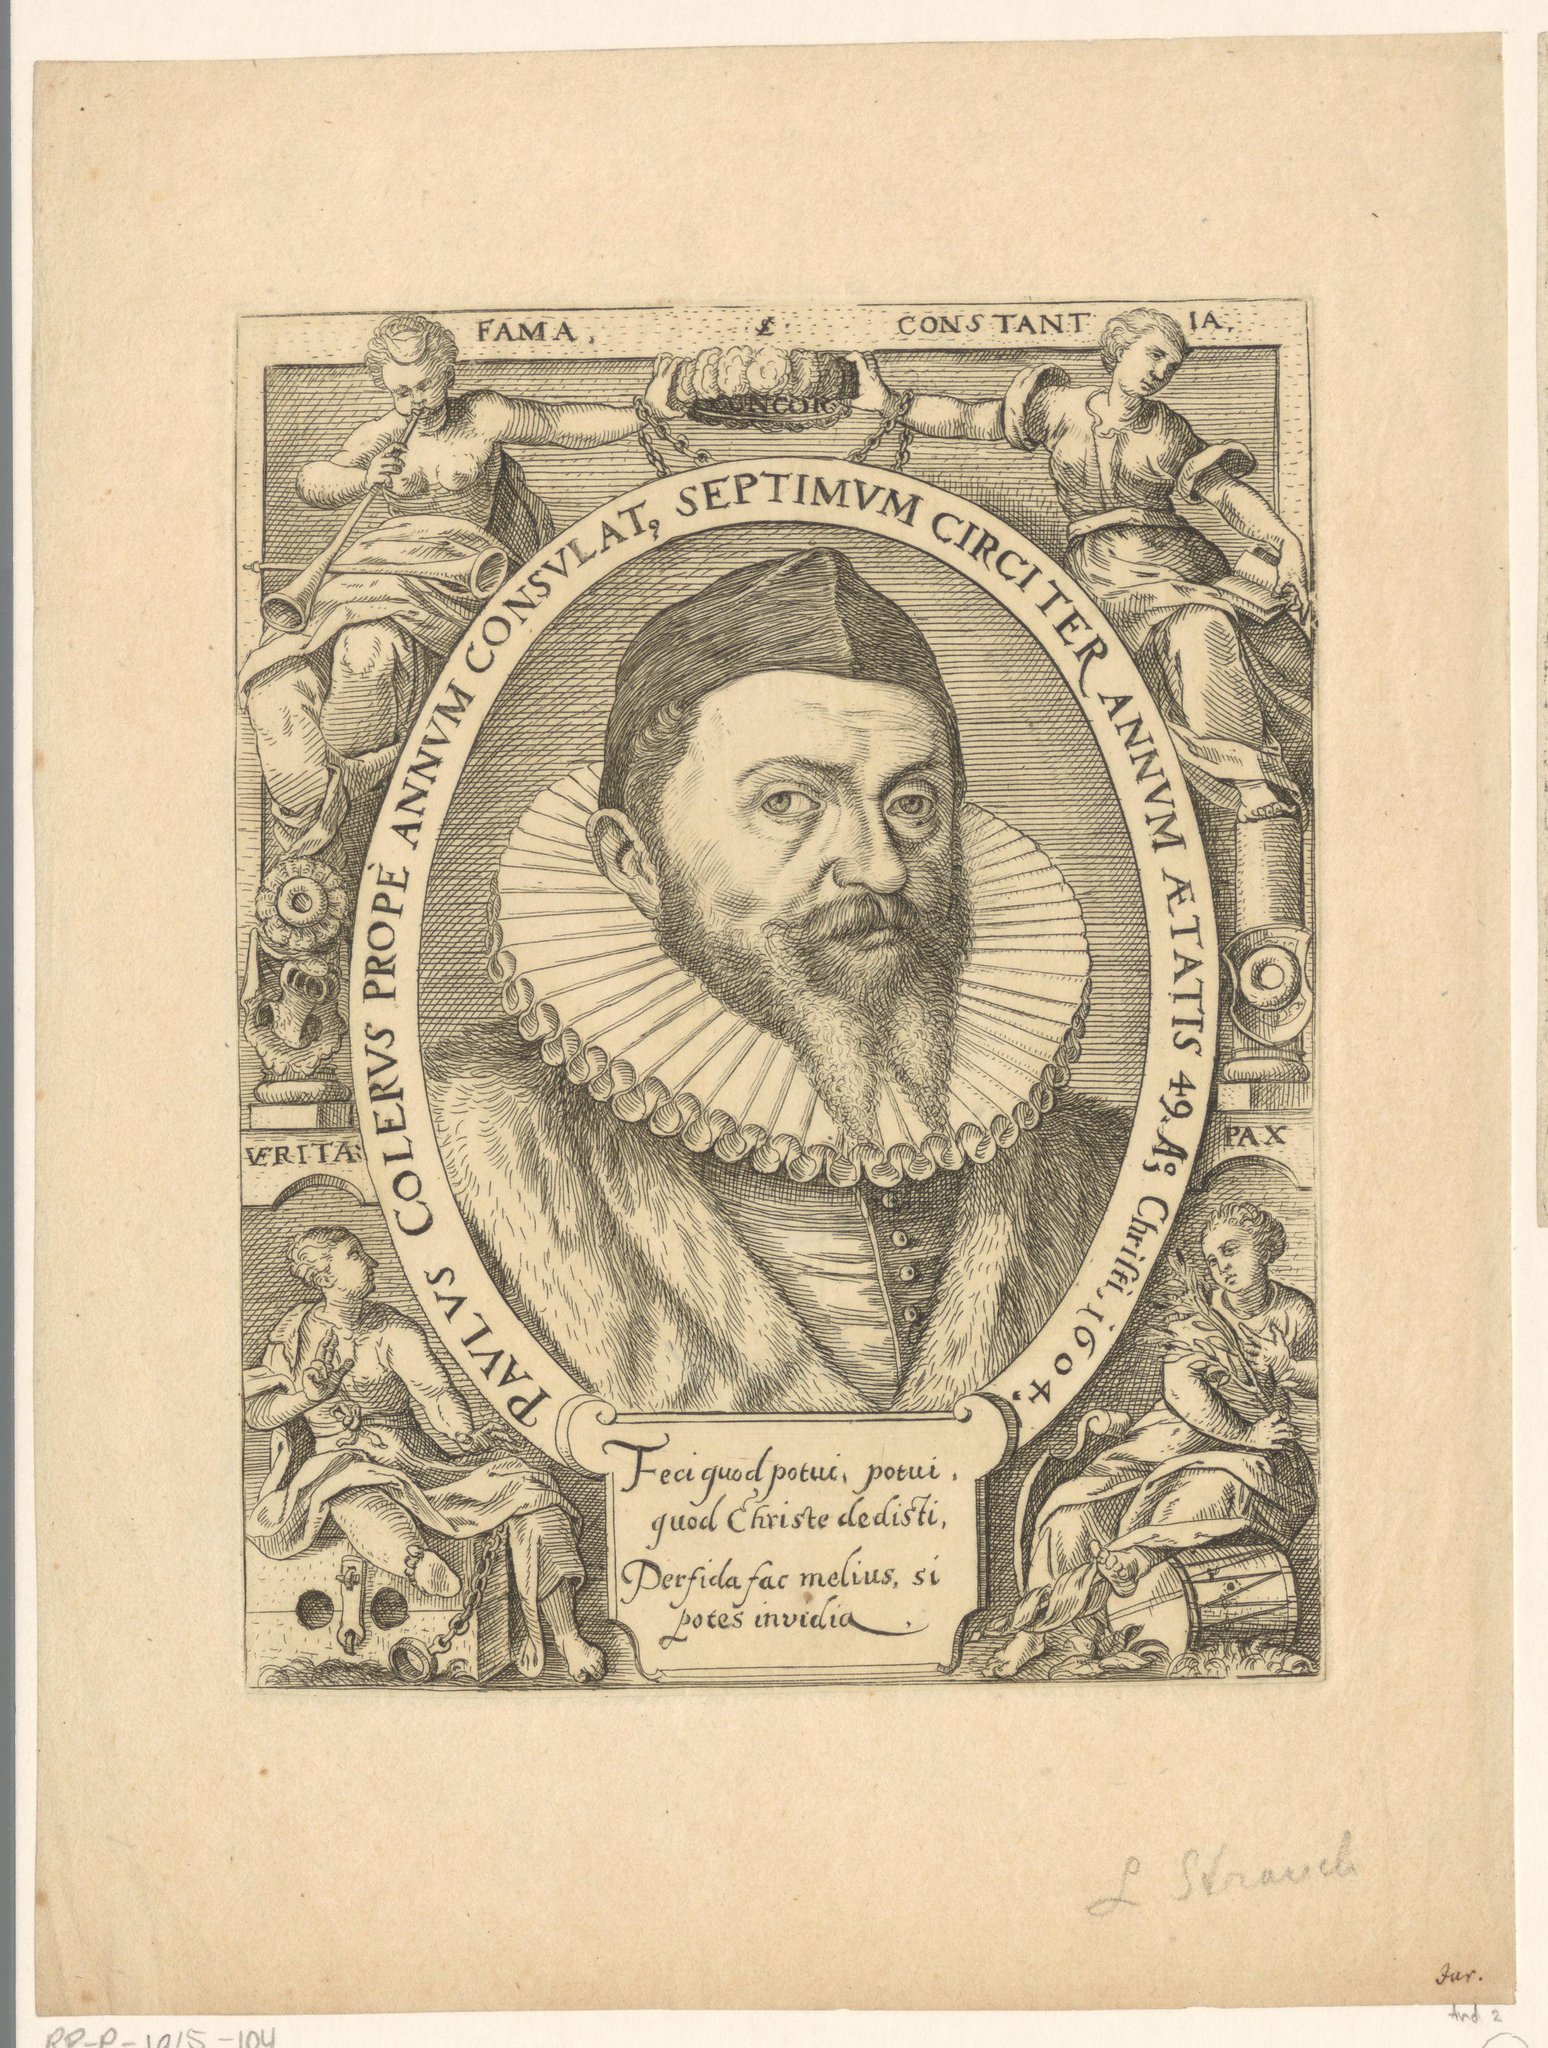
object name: print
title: Portret van Paulus Colerus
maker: lorenz strauch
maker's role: draughtsman, painter, print maker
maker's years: 1554-1630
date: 1604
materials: paper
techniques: etching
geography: nuremberg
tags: neck-gear ~ clothing (with name) (+ men's clothes), historical persons, truth; 'verità' (ripa), fama as roman personification, constancy, tenacity; 'costanza', 'tenacità' (ripa), pax as roman personification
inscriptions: collector's mark: Lugt 2228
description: Portret gevat in ovaal en omgeven door de allegorische figuren Faam, Kuisheid, Vrede en Waarheid. Midden onder een cartouche met vier regels tekst in Latijn.